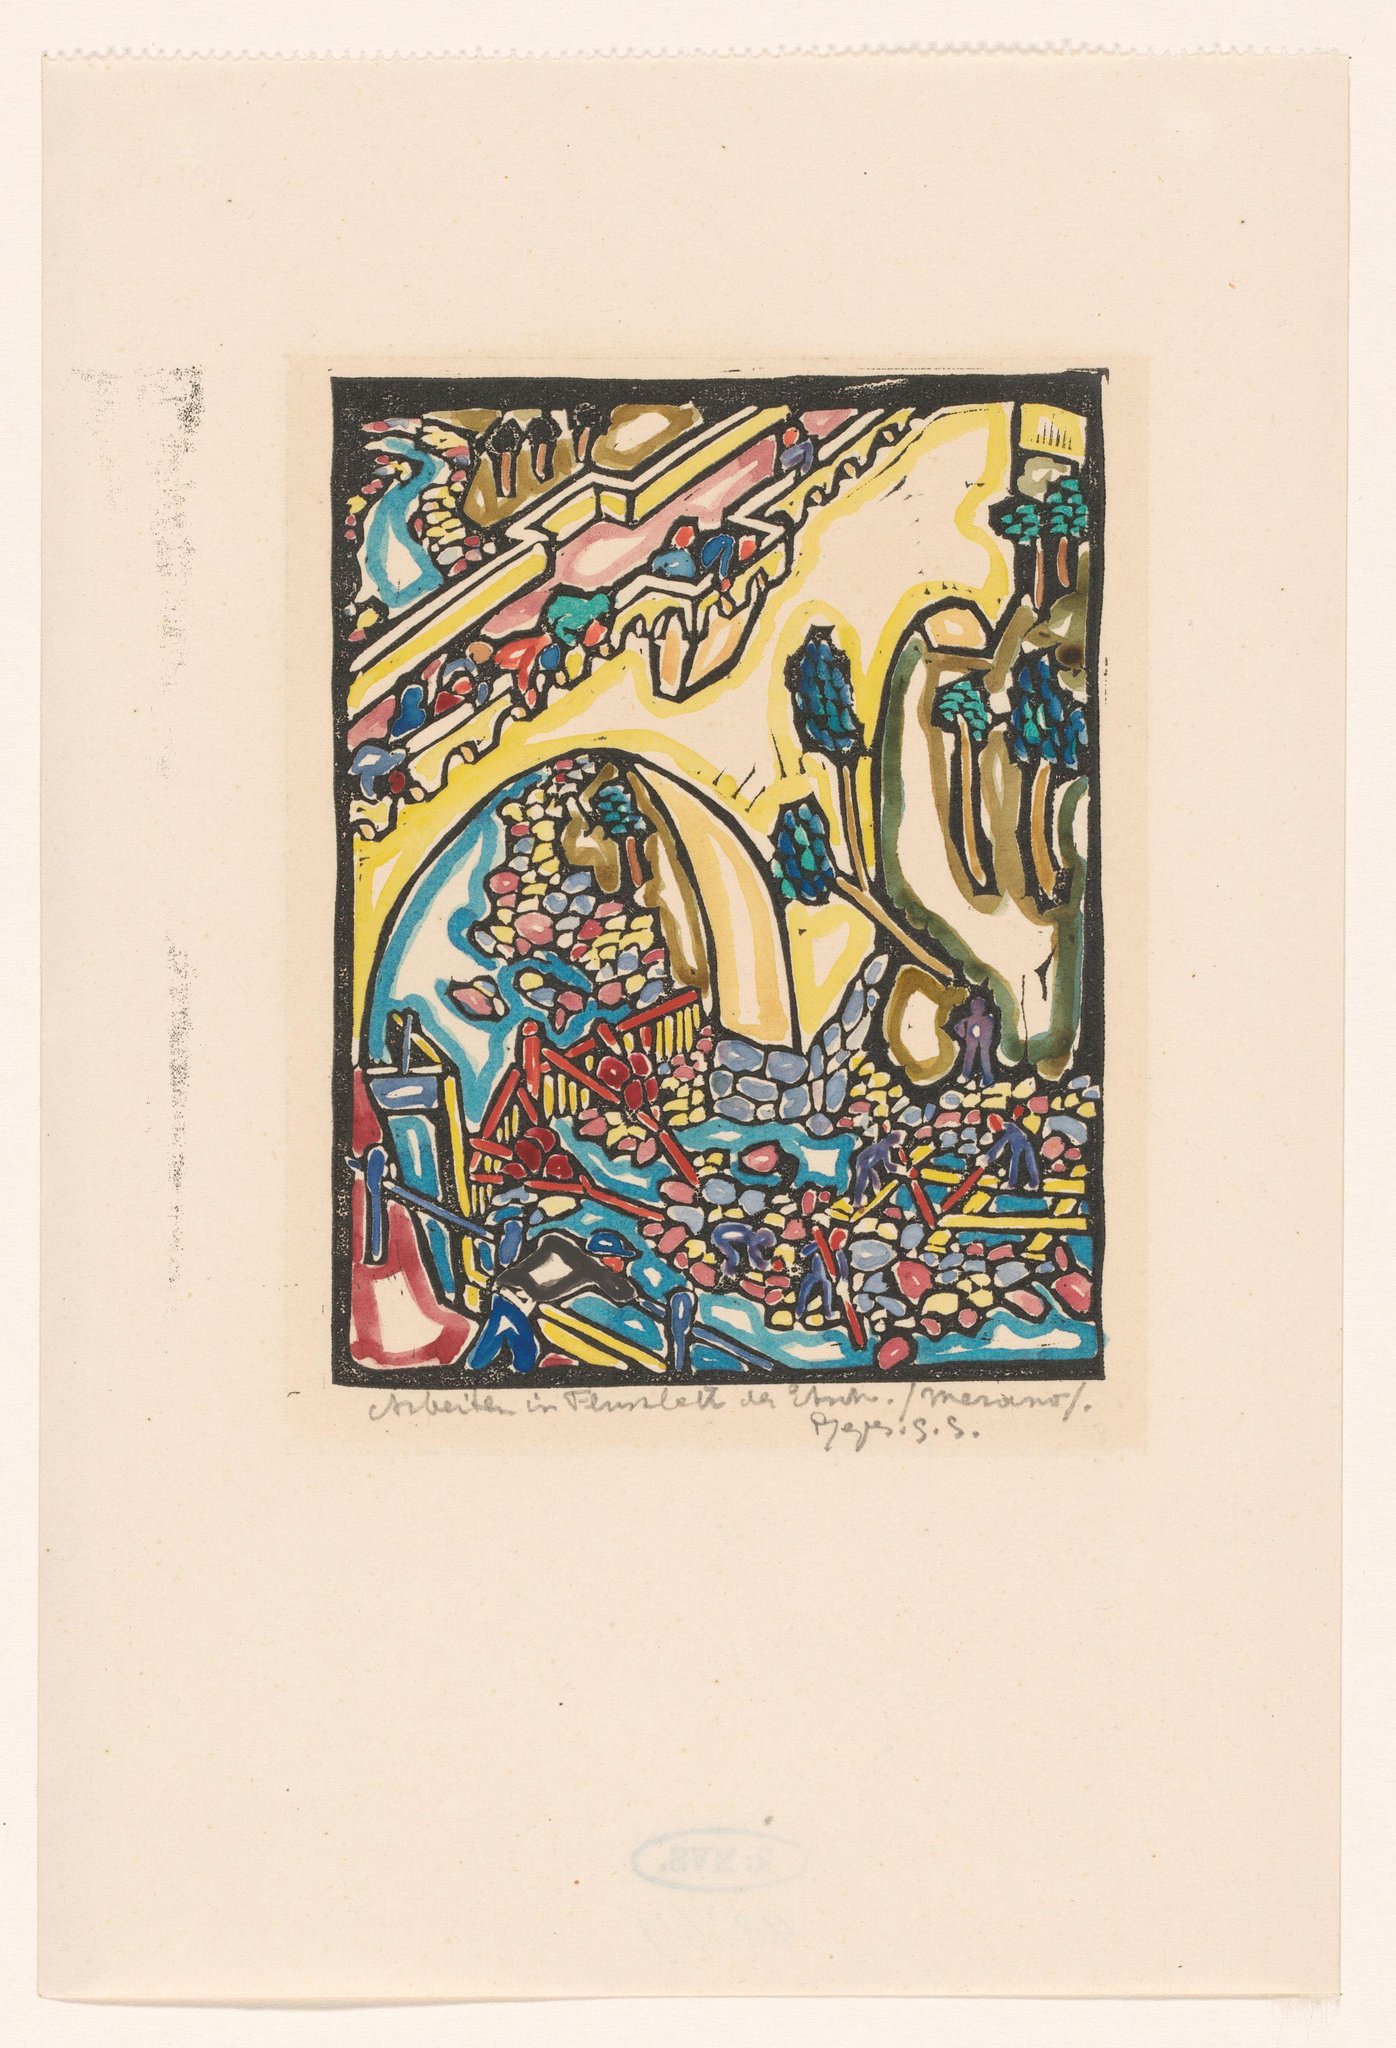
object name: print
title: Arbeiten in Flussbett der Etsch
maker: reijer stolk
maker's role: draughtsman, print maker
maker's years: 1896-1945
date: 1906-1945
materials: paper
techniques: hand coloring, linocut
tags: river, working class, labourers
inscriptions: collector's mark: Lugt 2228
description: Gezicht op de rivierbedding van de Adige in de stad Meran, waar arbeiders aan het werk zijn. Op de brug over de rivier staan toeschouwers.